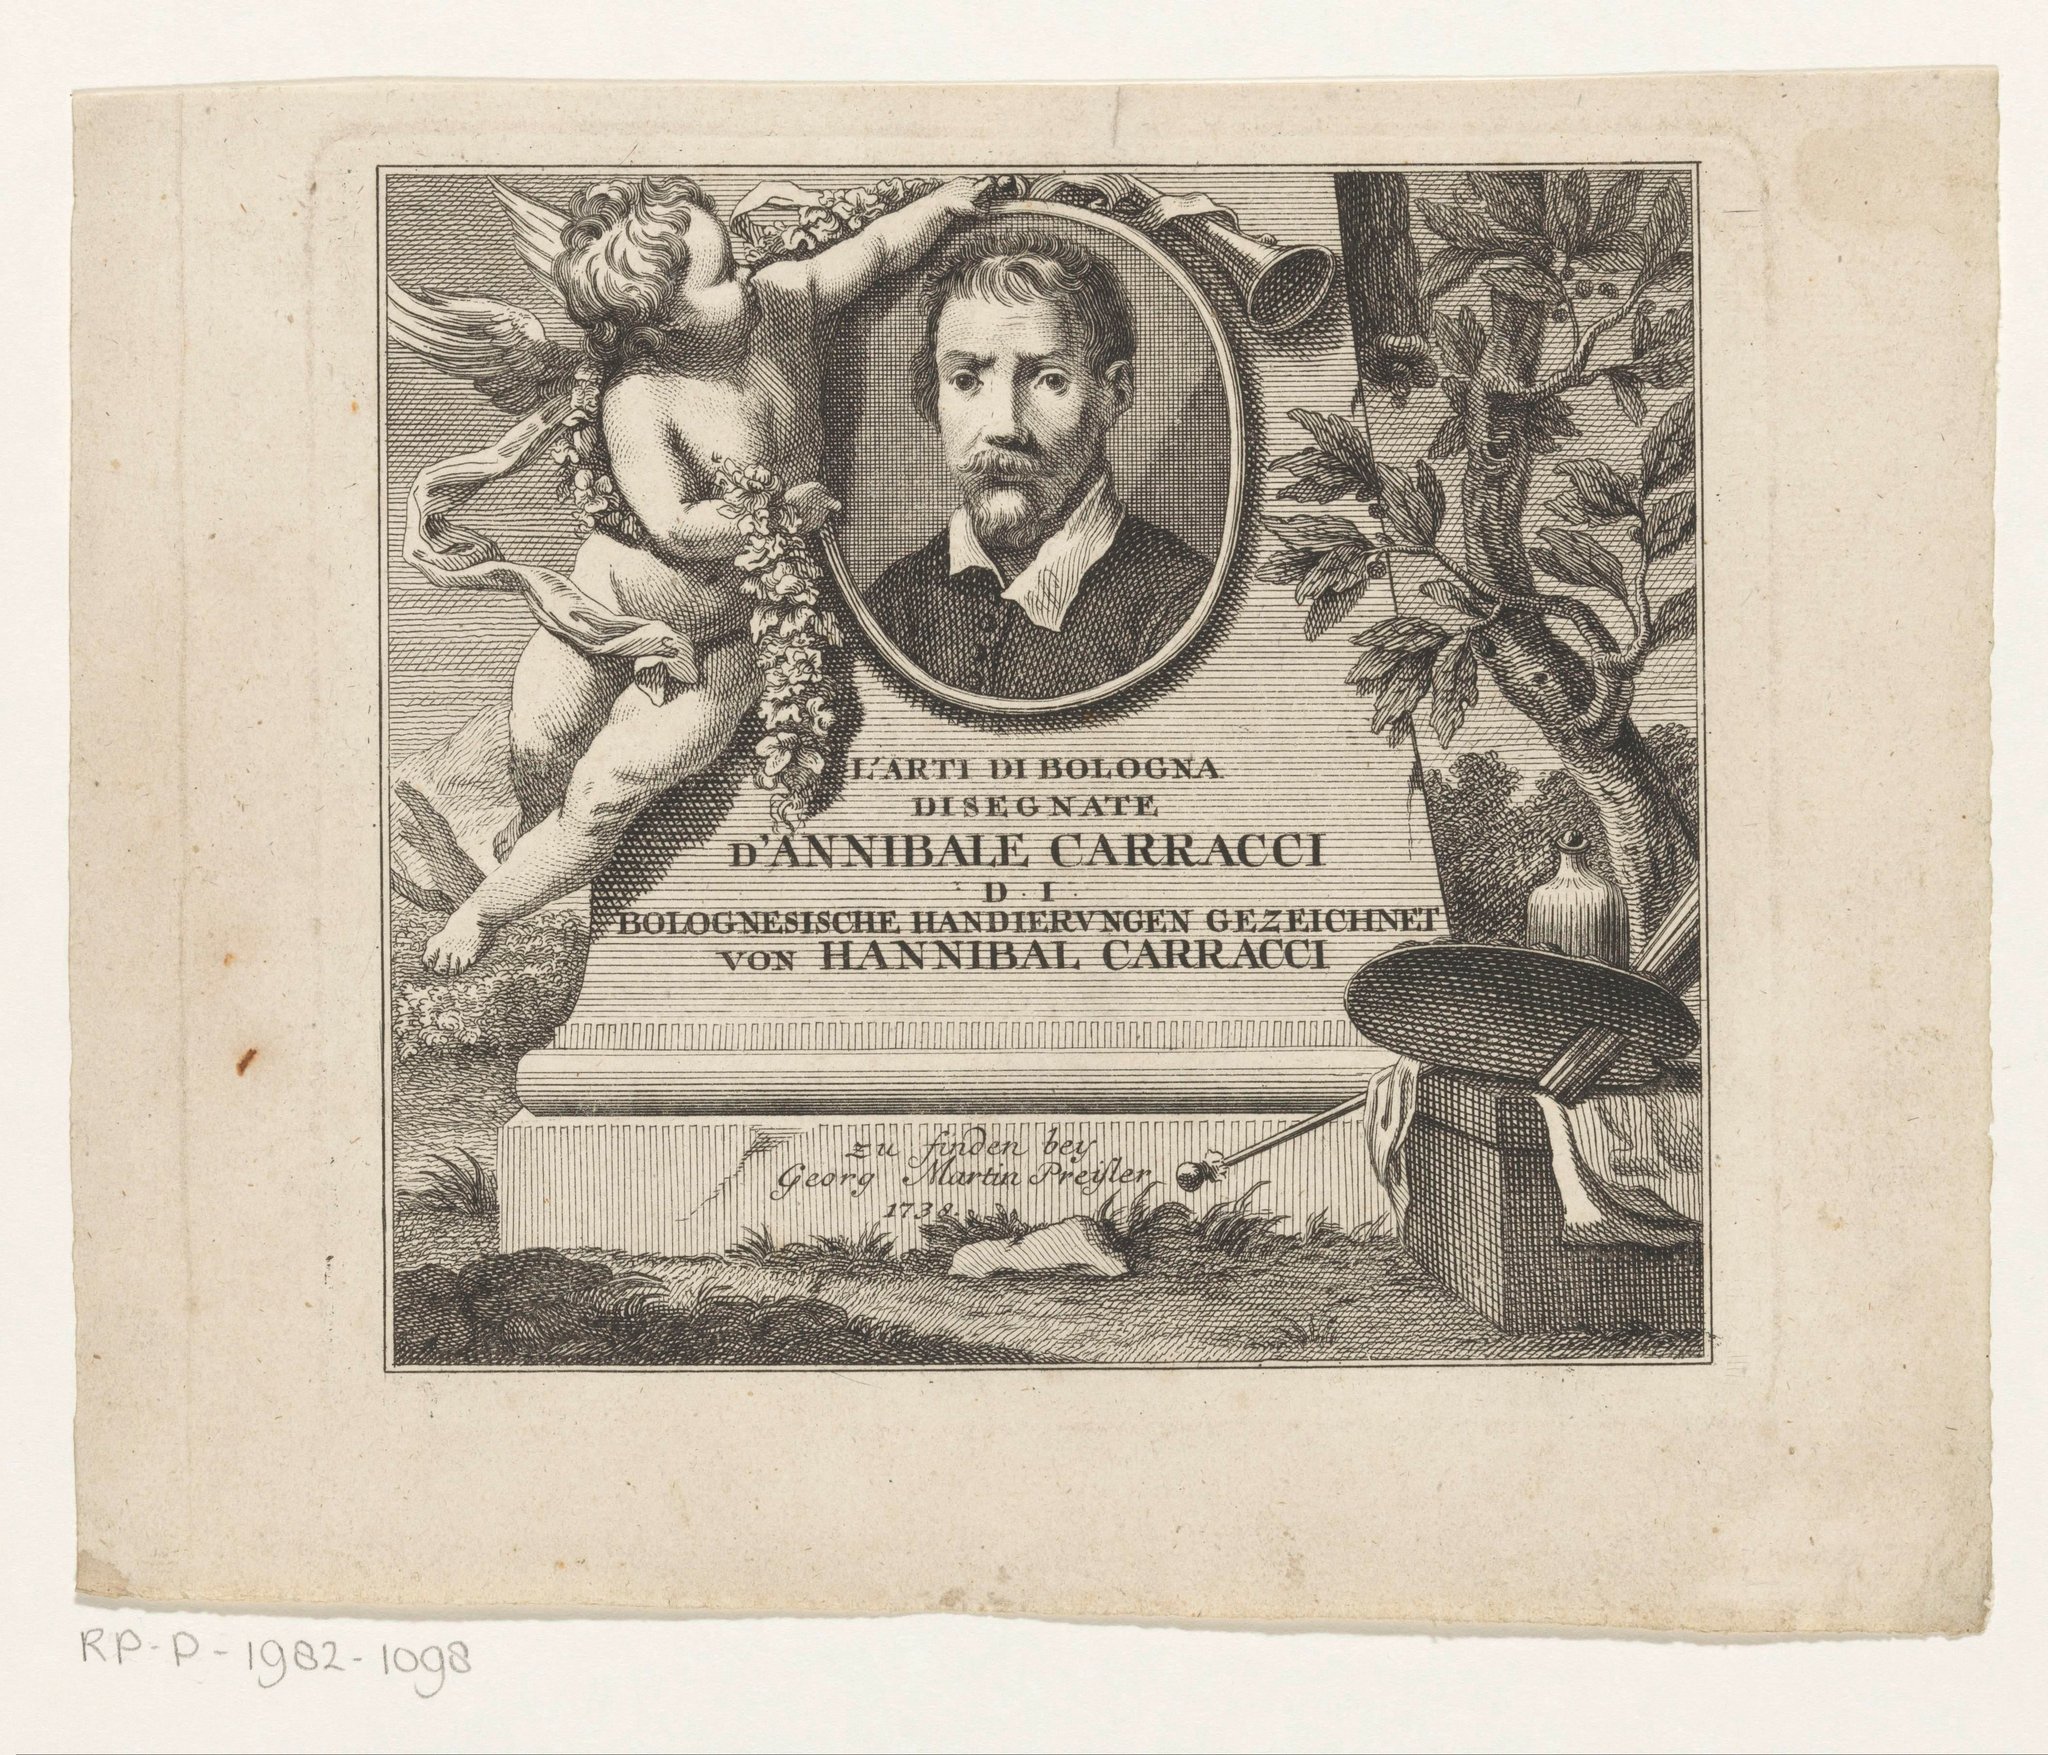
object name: print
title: L'Arti di Bologna designate d'Annibale Carracci / D.i. bolognesische handierungen gezeichnet von Hannibal Caracci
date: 1738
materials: paper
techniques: engraving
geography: nuremberg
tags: rome, print maker, draughtsman, annibale carracci, portrait, self-portrait of painter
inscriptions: collector's mark: Lugt 2228, collector's mark: Lugt 2760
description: Monument met ovaal portretmedaillon met de schilder Annibale Carracci. Links decoreert een putto het medaillon met een guirlande. Rechts liggen schildersattributen.